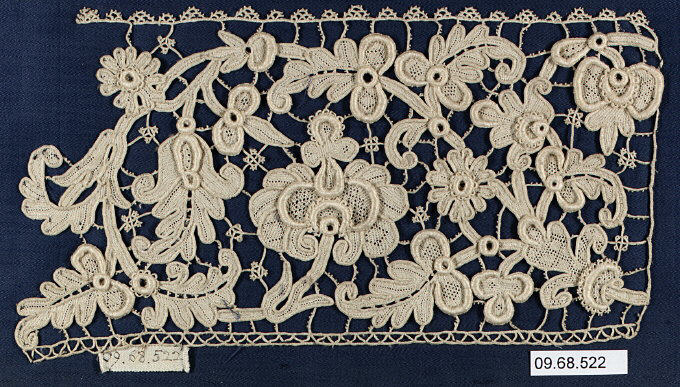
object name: fragment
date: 1801-1900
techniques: lace